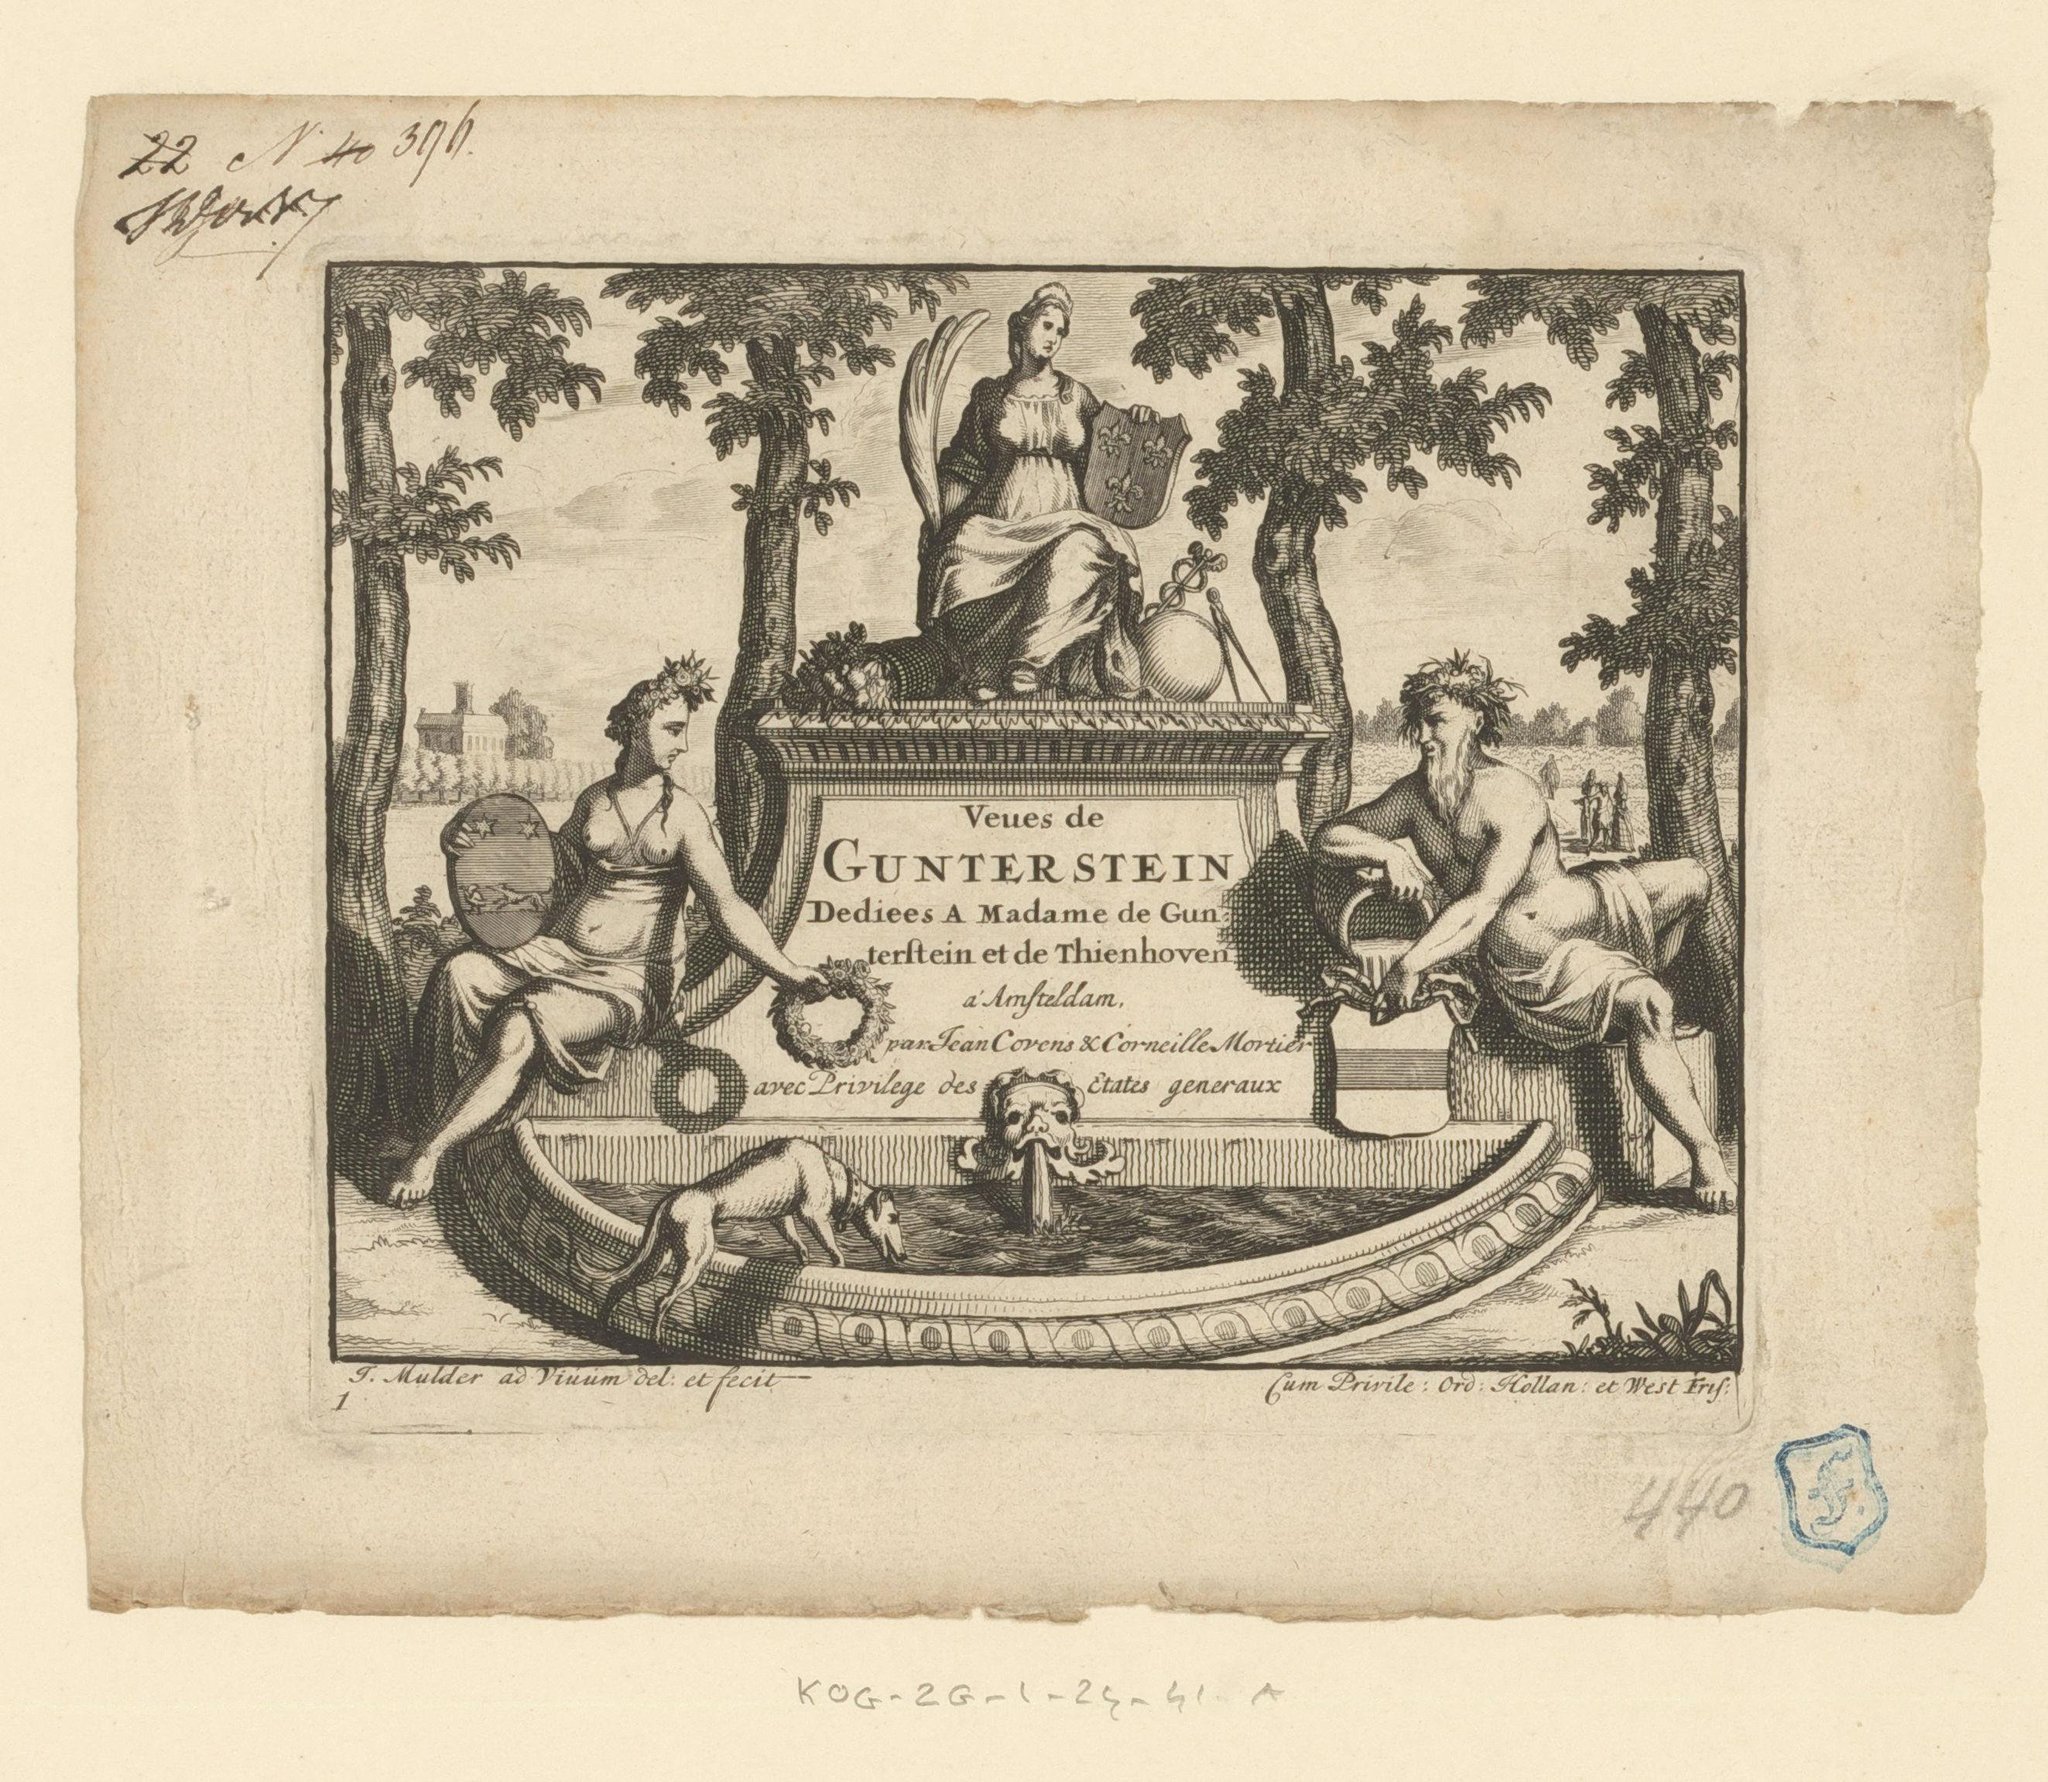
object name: print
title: Veues de Gunterstein dediees a madame de Gunterstein et de Thienhoven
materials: paper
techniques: engraving, etching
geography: amsterdam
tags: magdalena poulle, 'cornucopia', horn of plenty, ornamental fountain, fame; 'fama', 'fama buona', 'fama chiara' (ripa), caduceus (staff with two snakes, attribute of mercury), armorial bearing, heraldry, dog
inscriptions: collector's mark: Lugt 963, stamp:, collector's mark: Lugt 1641, stamp:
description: Fontein met een standbeeld van de Faam met palmtak en een Frans wapenschild in de handen. Naast haar liggen een caduceus, globe, passer en een hoorn des overvloeds. De vrouw links toont het wapenschild van Magdalena Poulle, de eigenaresse van Kasteel Gunterstein in Breukelen. Rechts een stroomgod. Links op de achtergrond het kasteel, op de voorgrond een hond. Onderwerpsrubrieken binnen de Atlas Zeden en Gewoonten: Zeden en Gewoonten in Engeren Zin, De Woning. Kastelen en buitenplaatsen. Utrecht (vervolg.).